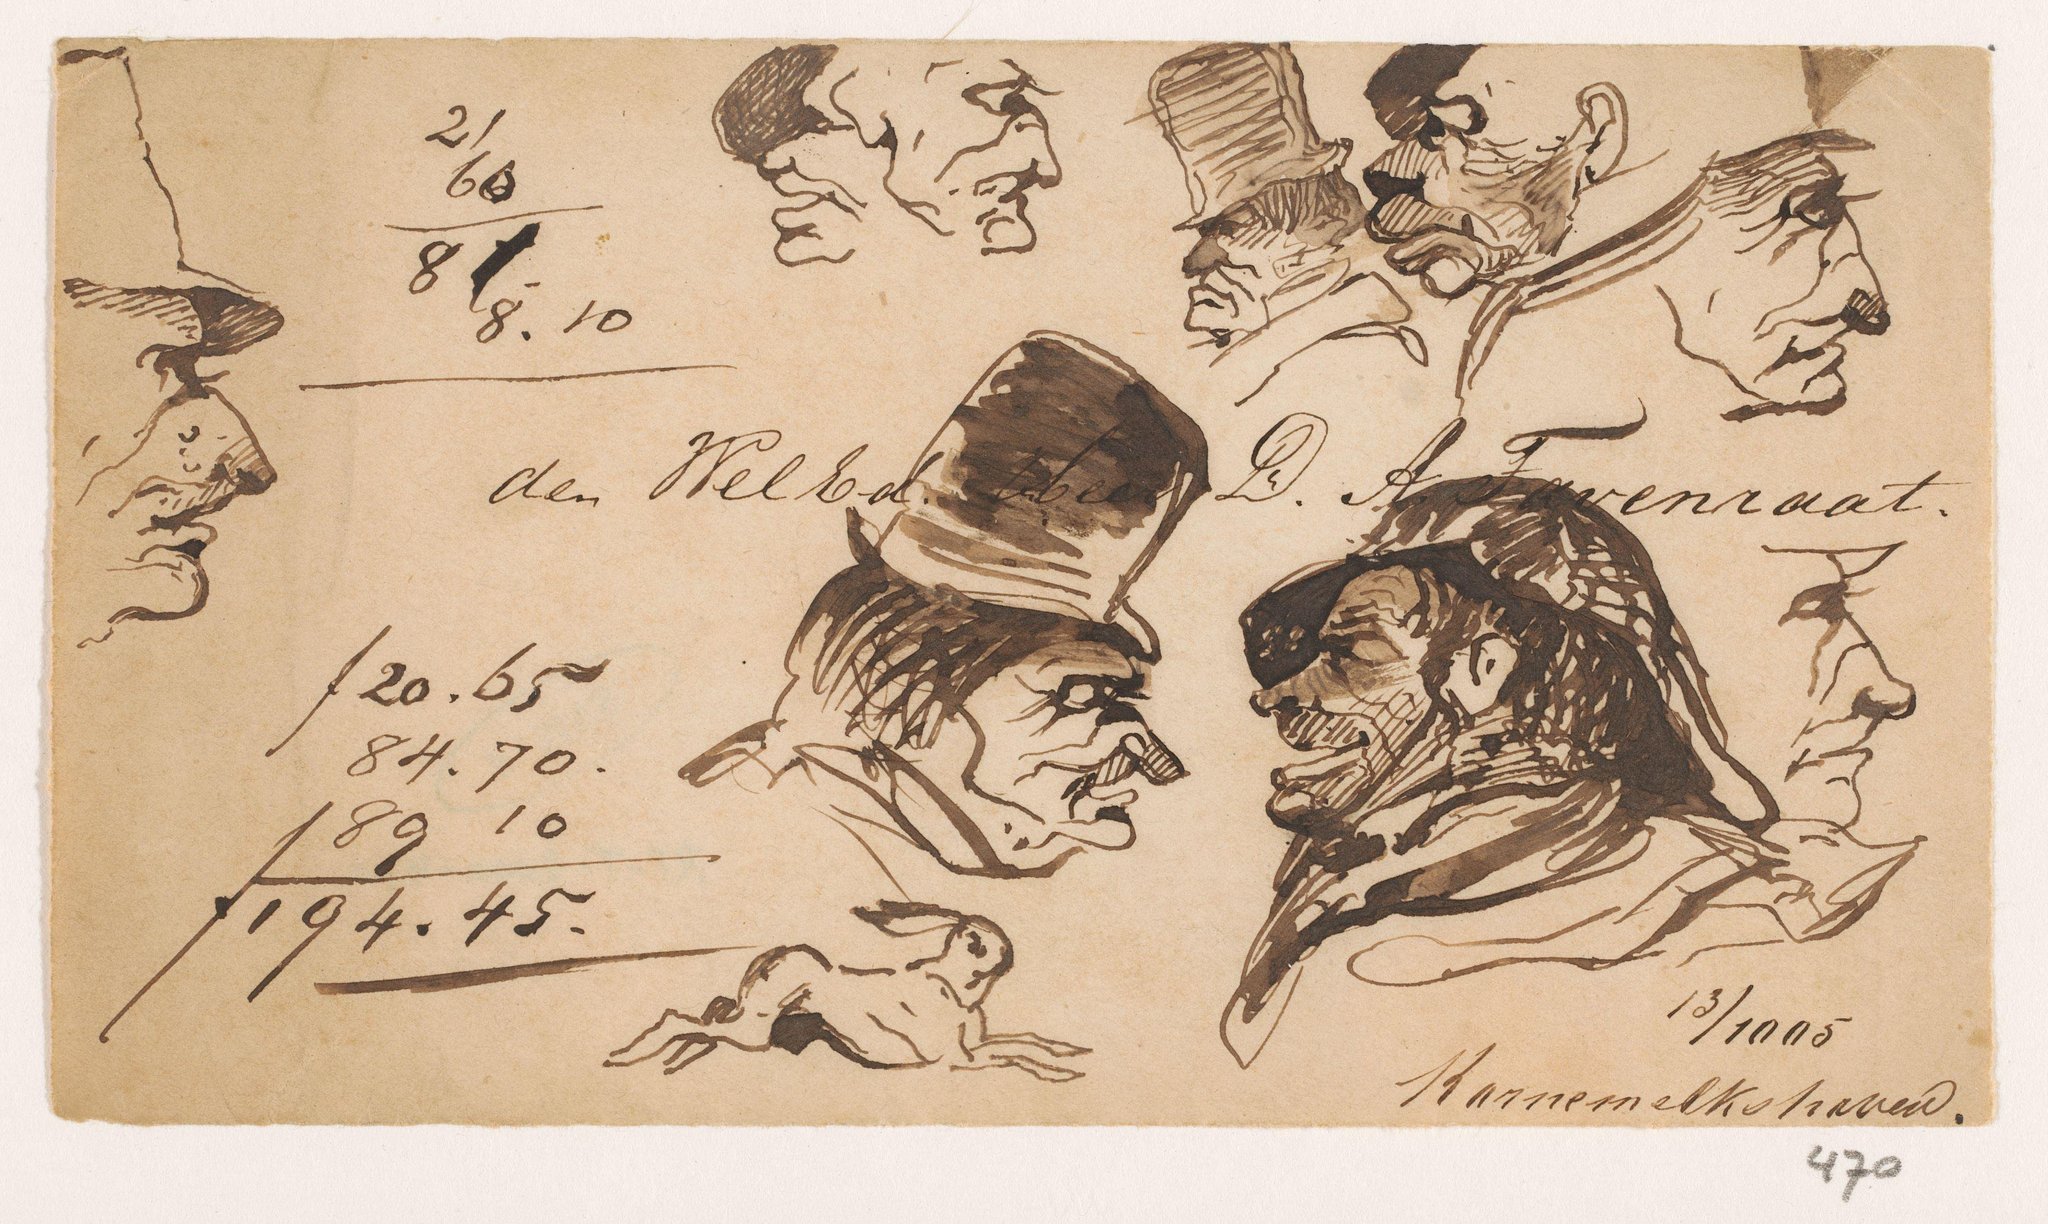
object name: drawing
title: Koppen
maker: johannes tavenraat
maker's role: draughtsman, painter, print maker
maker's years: 1809-1881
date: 1840-1880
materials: ink, paper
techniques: brush, pen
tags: caricatures (human types)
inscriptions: collector's mark: Lugt 2228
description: Koppen. Getekend op een fragment van een envelop gericht aan D.A. Tavenraat.